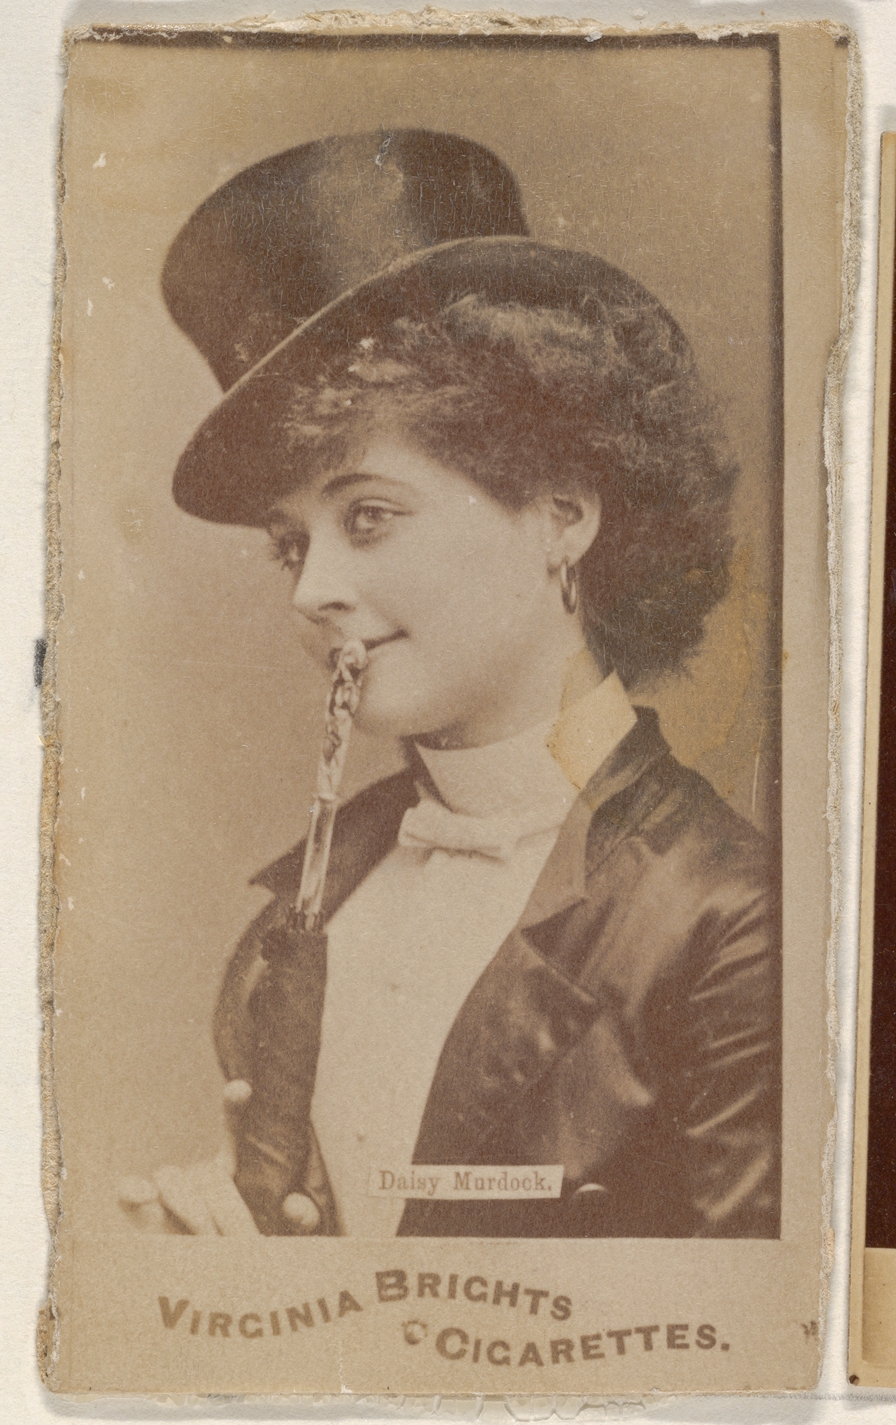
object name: photograph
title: Daisy Murdoch, from the Actors and Actresses series (N45, Type 1) for Virginia Brights Cigarettes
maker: allen & ginter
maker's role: publisher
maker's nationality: american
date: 1888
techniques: albumen silver print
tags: portraits,women,actresses